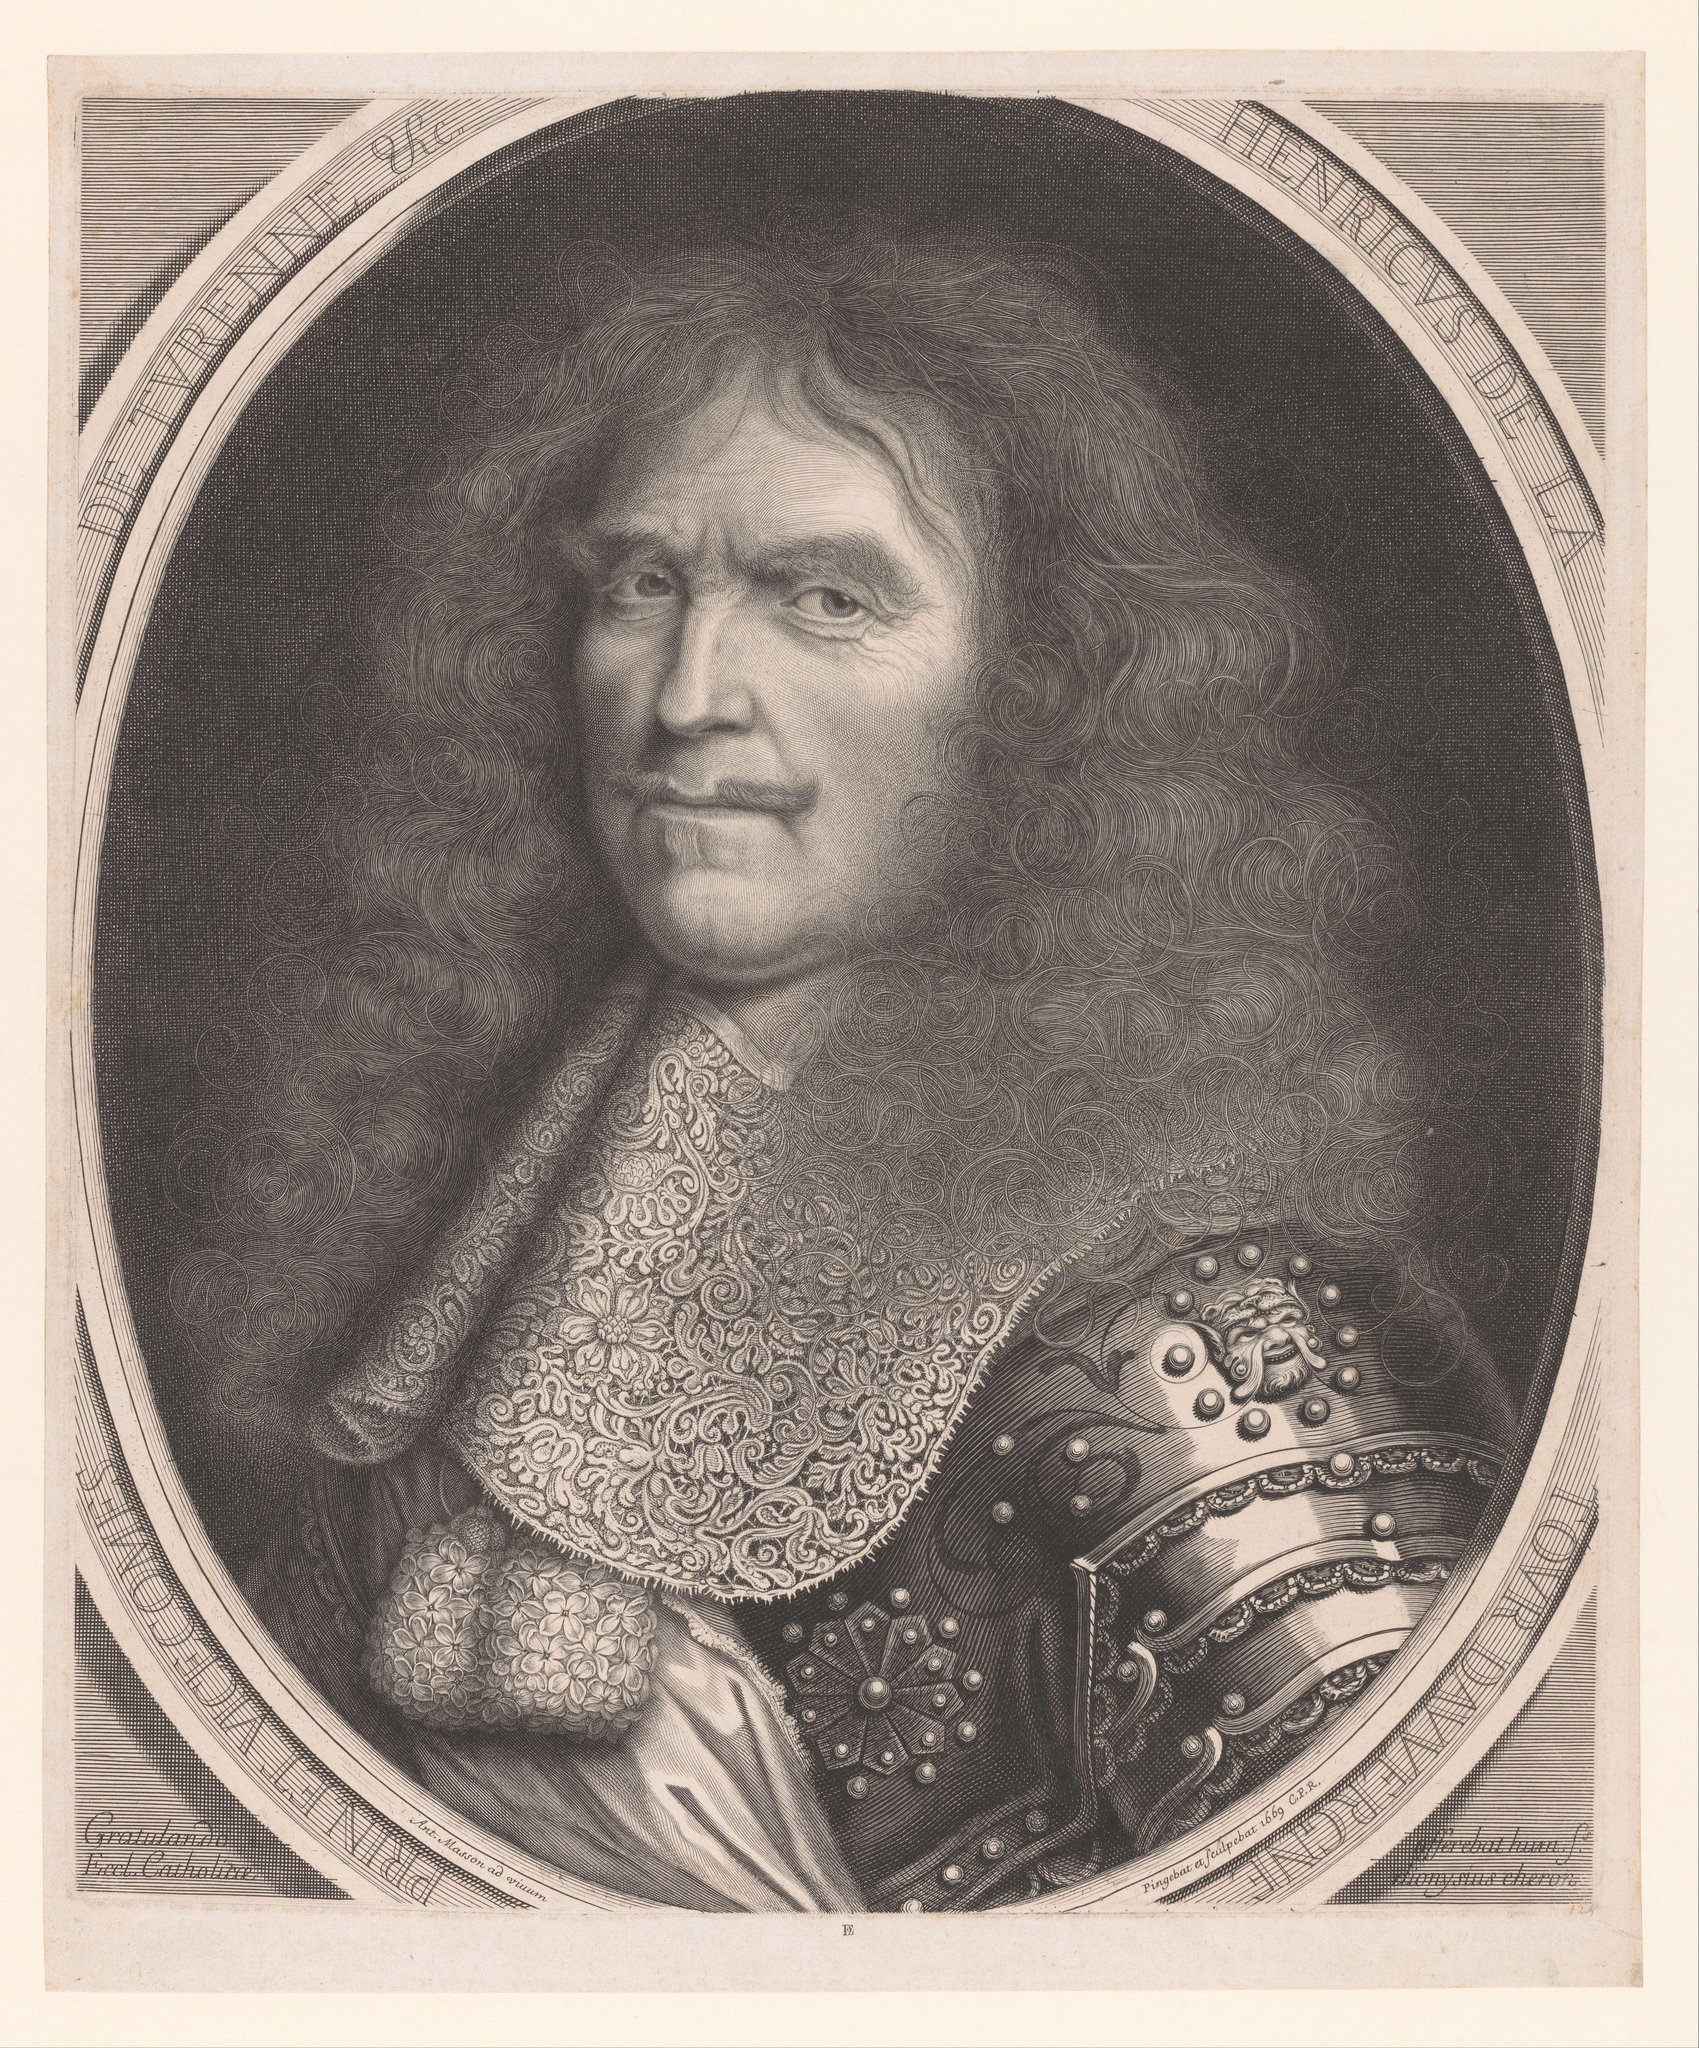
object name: print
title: Portret van Henri de La Tour d'Auvergne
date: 1669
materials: paper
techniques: engraving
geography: france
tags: commander-in-chief, general, marshal, historical persons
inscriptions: collector's mark: Lugt 2228, collector's mark: Lugt 741, collector's mark: Lugt 2760, collector's mark: Lugt 2161